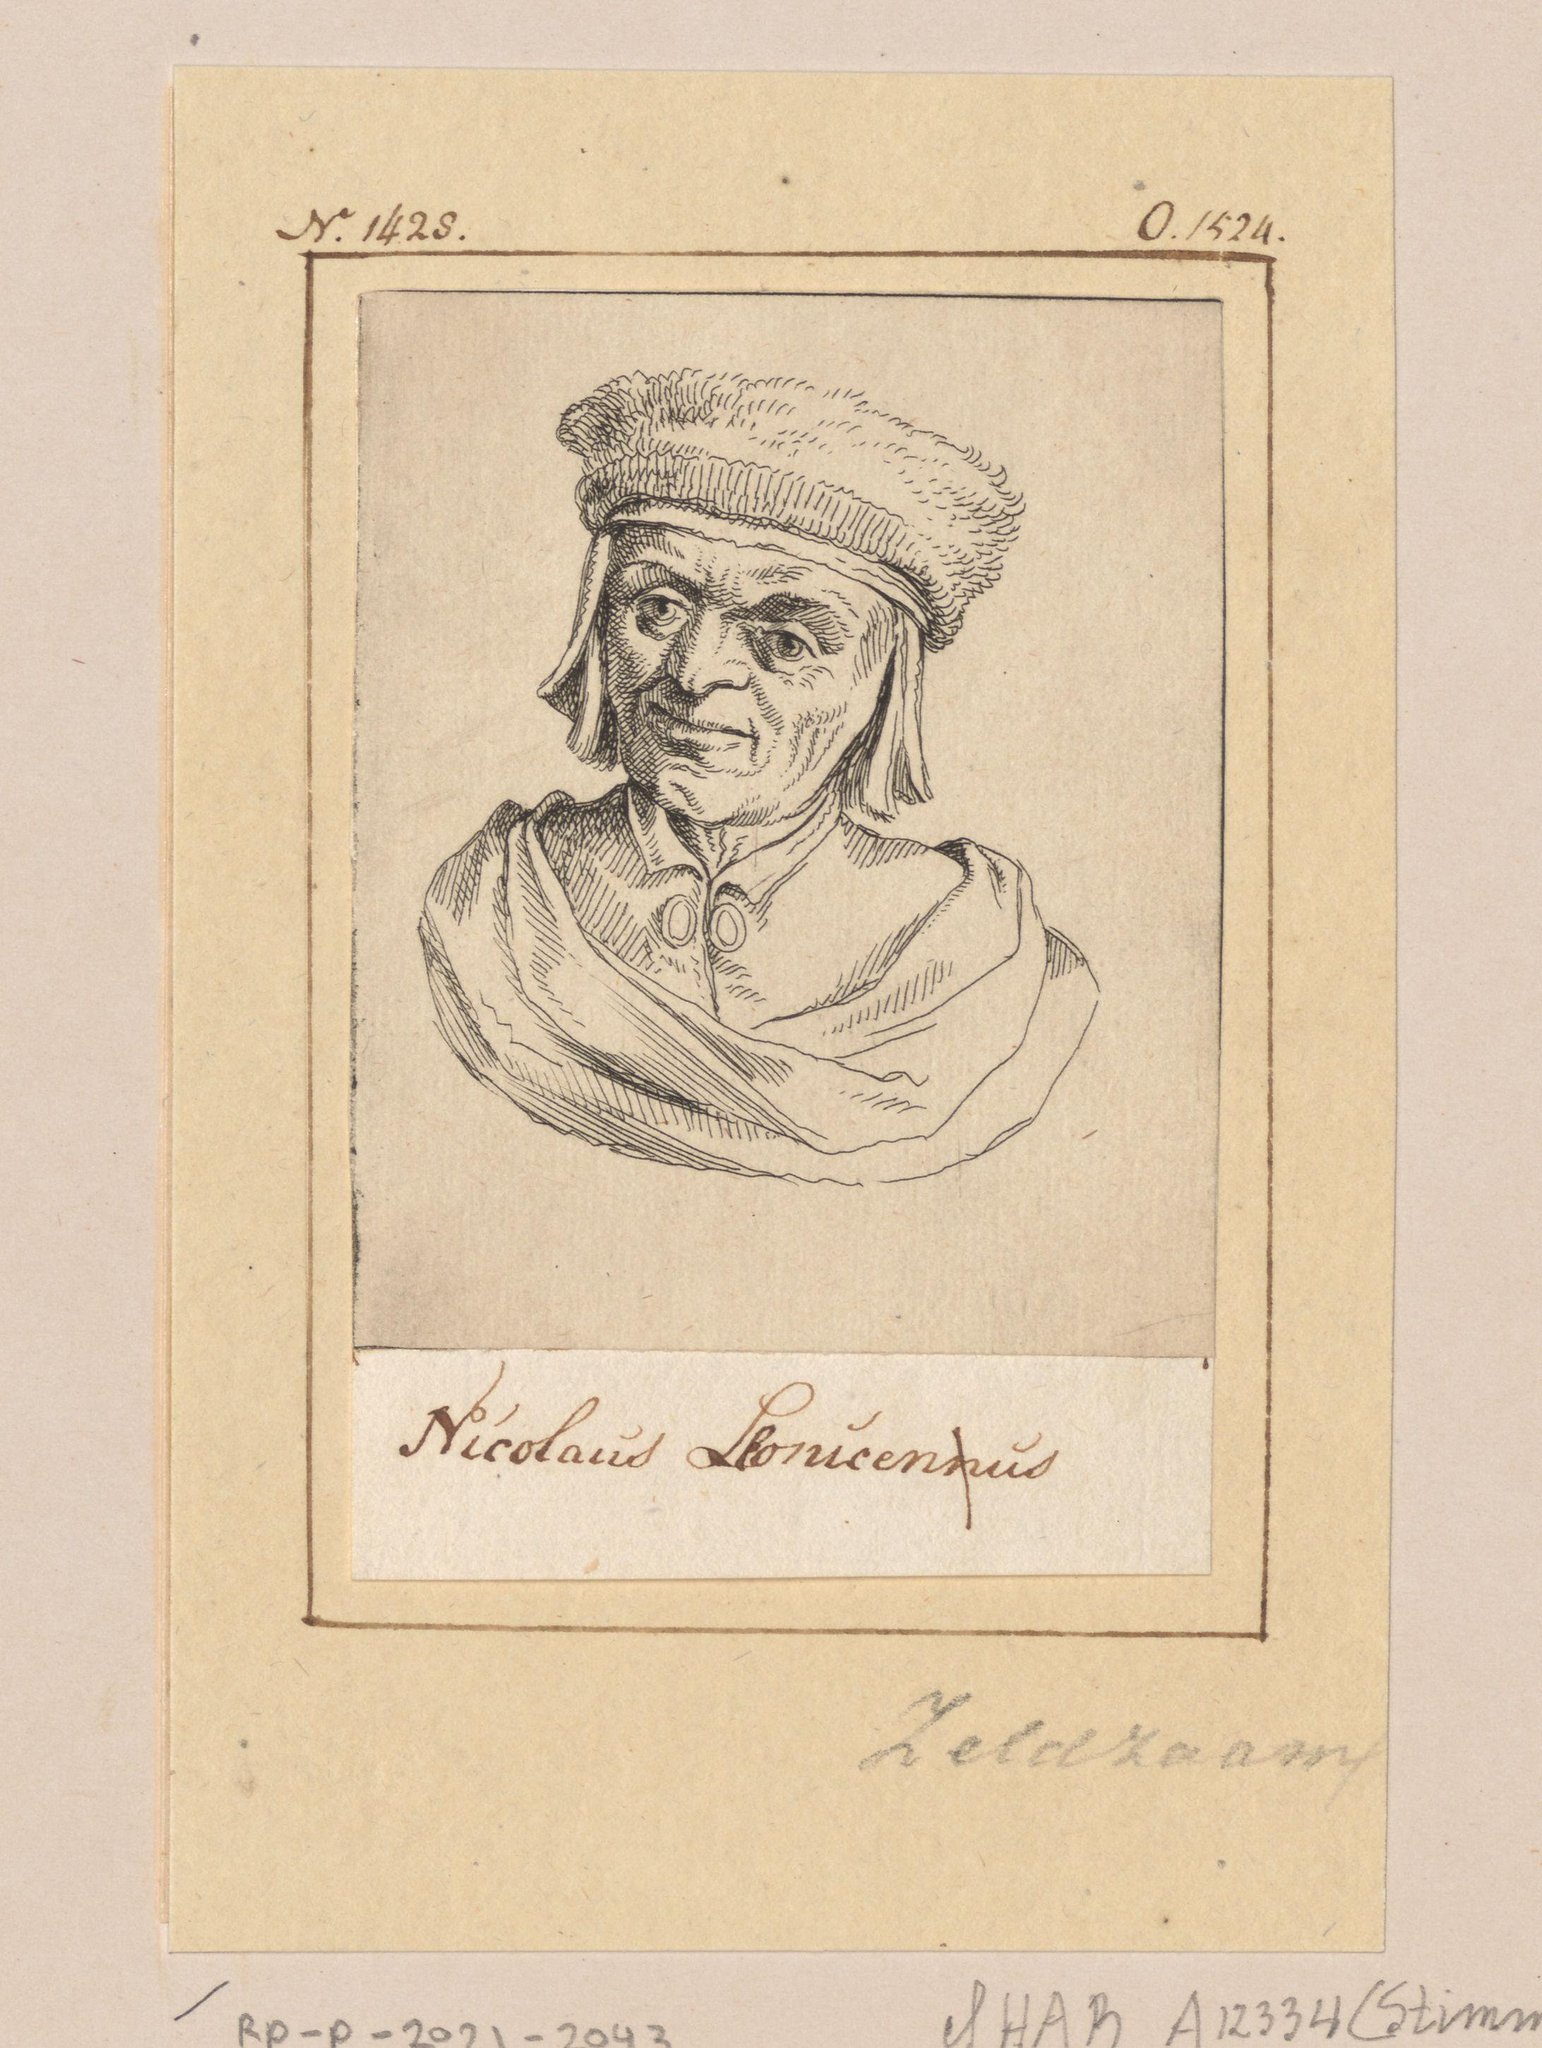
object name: print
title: Portret van Niccolò Leoniceno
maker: Anonymous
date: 1600-1699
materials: paper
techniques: etching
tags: historical persons, physician, doctor (+ portrait of scholar, scientist)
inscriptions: inscription: ‘N. 1428/ O. 1524’, inscription: ‘Nicolaus Leonicennus’, inscription: ‘zeldzaam’